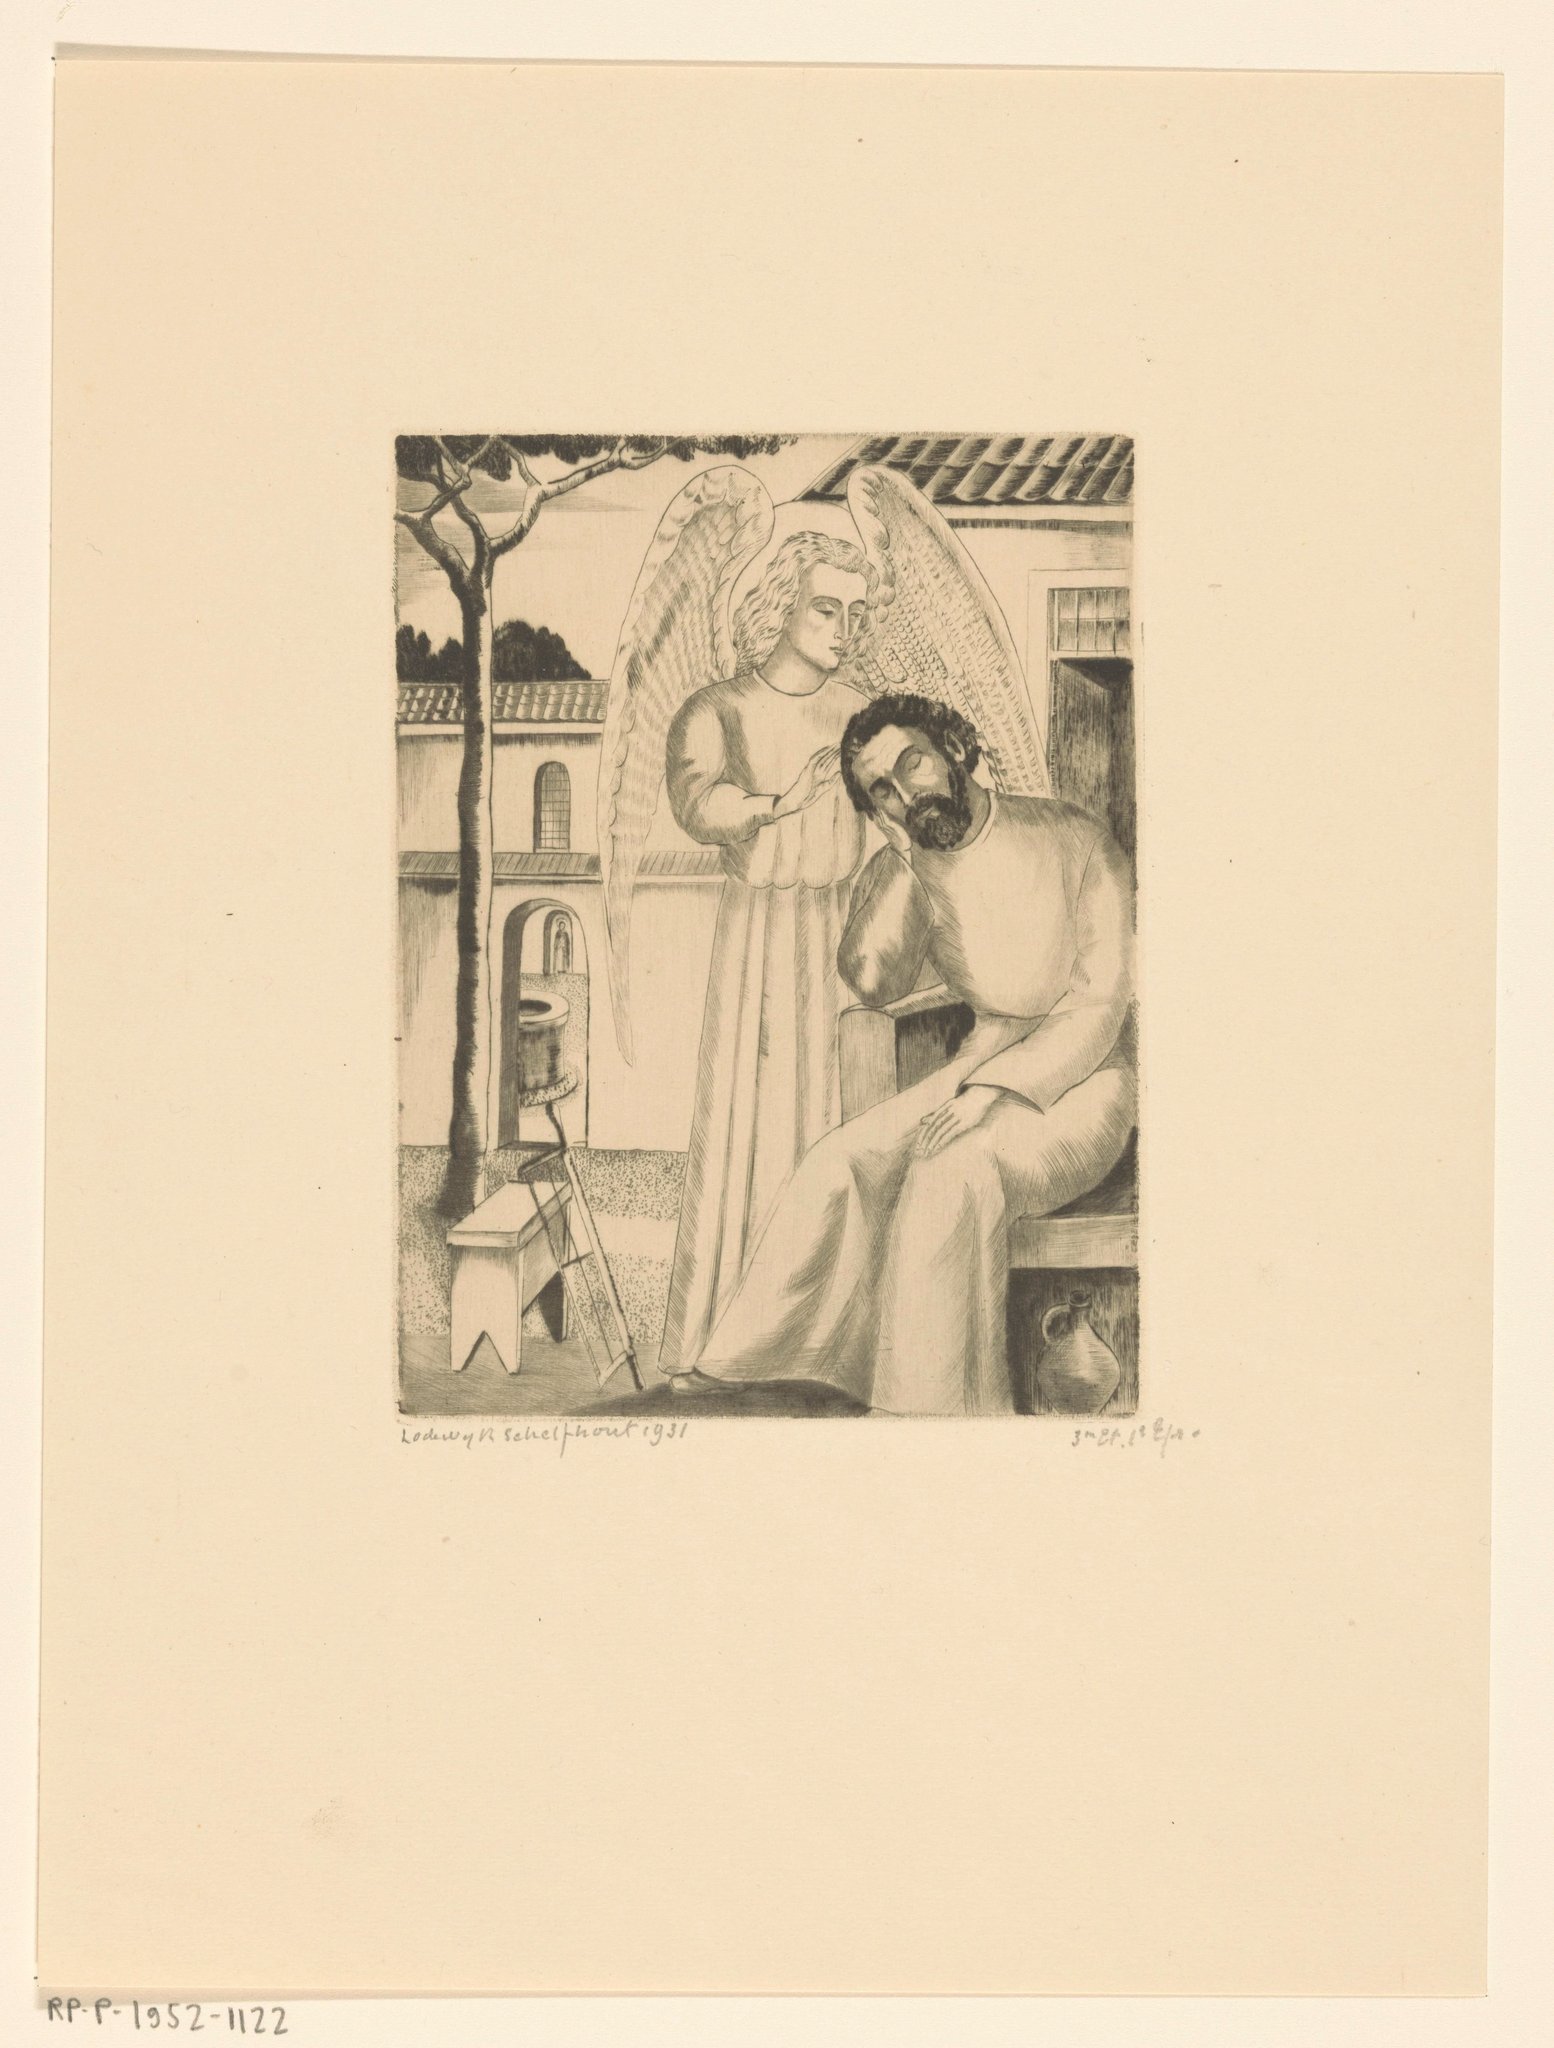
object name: print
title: Jozefs droom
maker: lodewijk schelfhout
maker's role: draughtsman, print maker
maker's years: 1881-1943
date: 1931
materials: paper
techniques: drypoint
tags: the foster-father of christ, joseph of nazareth, husband of mary; possible attributes: flowering rod or wand, lily, carpenter's tools, dream, angels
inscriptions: collector's mark: Lugt 2228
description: Rechts op de voorgrond Jozef, slapend op een bank in een tuin. Achter hem de aartsengel Gabriël, die aan Jozef verschijnt in een droom. Links op de voorgrond het timmergereedschap van Jozef. Op de achtergrond een huis met een ommuurde tuin.